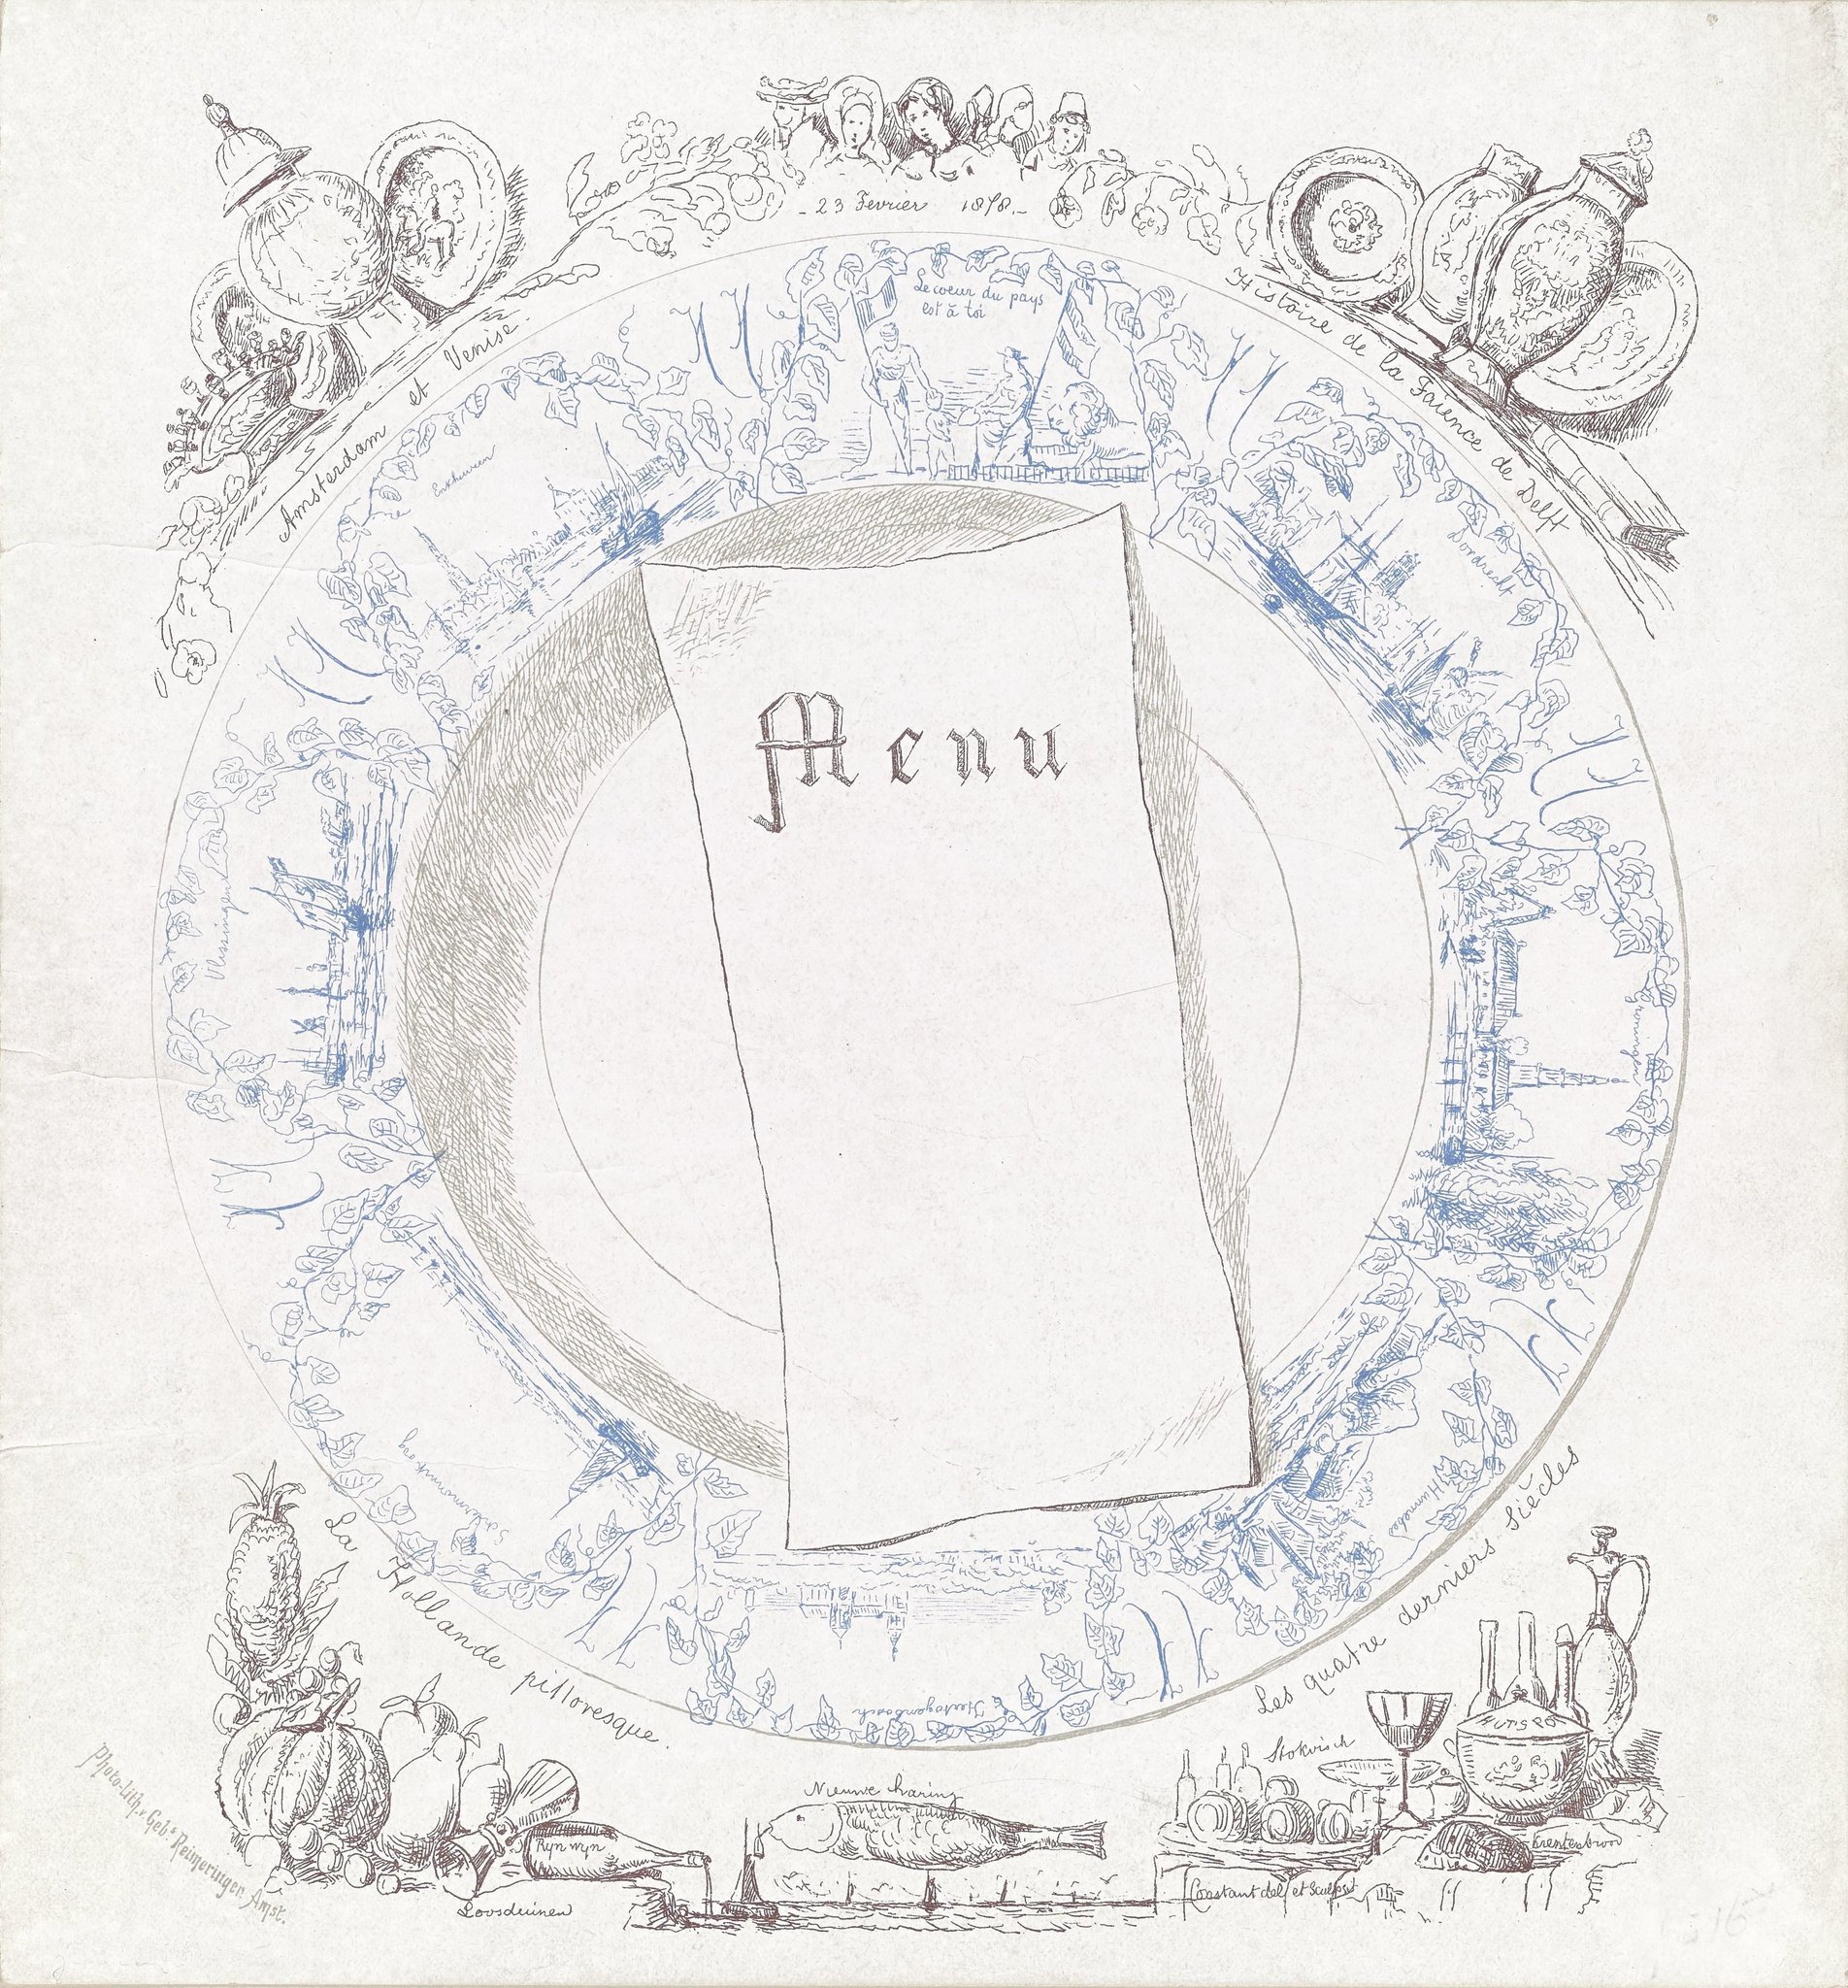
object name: print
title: Menu voor een maaltijd aangeboden aan Henry Havard, 1878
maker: constant (19e eeuw)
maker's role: print maker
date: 1802-1878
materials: paper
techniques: photolithography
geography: amsterdam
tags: paris, eating and drinking, dish, plate, saucer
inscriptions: collector's mark: Lugt 2228, inscription: ‘Menu v/d. maaltijd aangeboden aan Henri Havard.’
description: Menukaart (oningevuld) voor een maaltijd aangeboden aan Henry Havard op 23 februari 1878, bij de viering van de publicatie van Havards boek over Delfts aardewerk, getiteld 'Histoire de la faïence de Delft'. Een menu liggend op een Delfts blauw bord versierd met gezichten van Nederlandse plaatsen. Hieromheen Nederlands eten en drinken en servies.